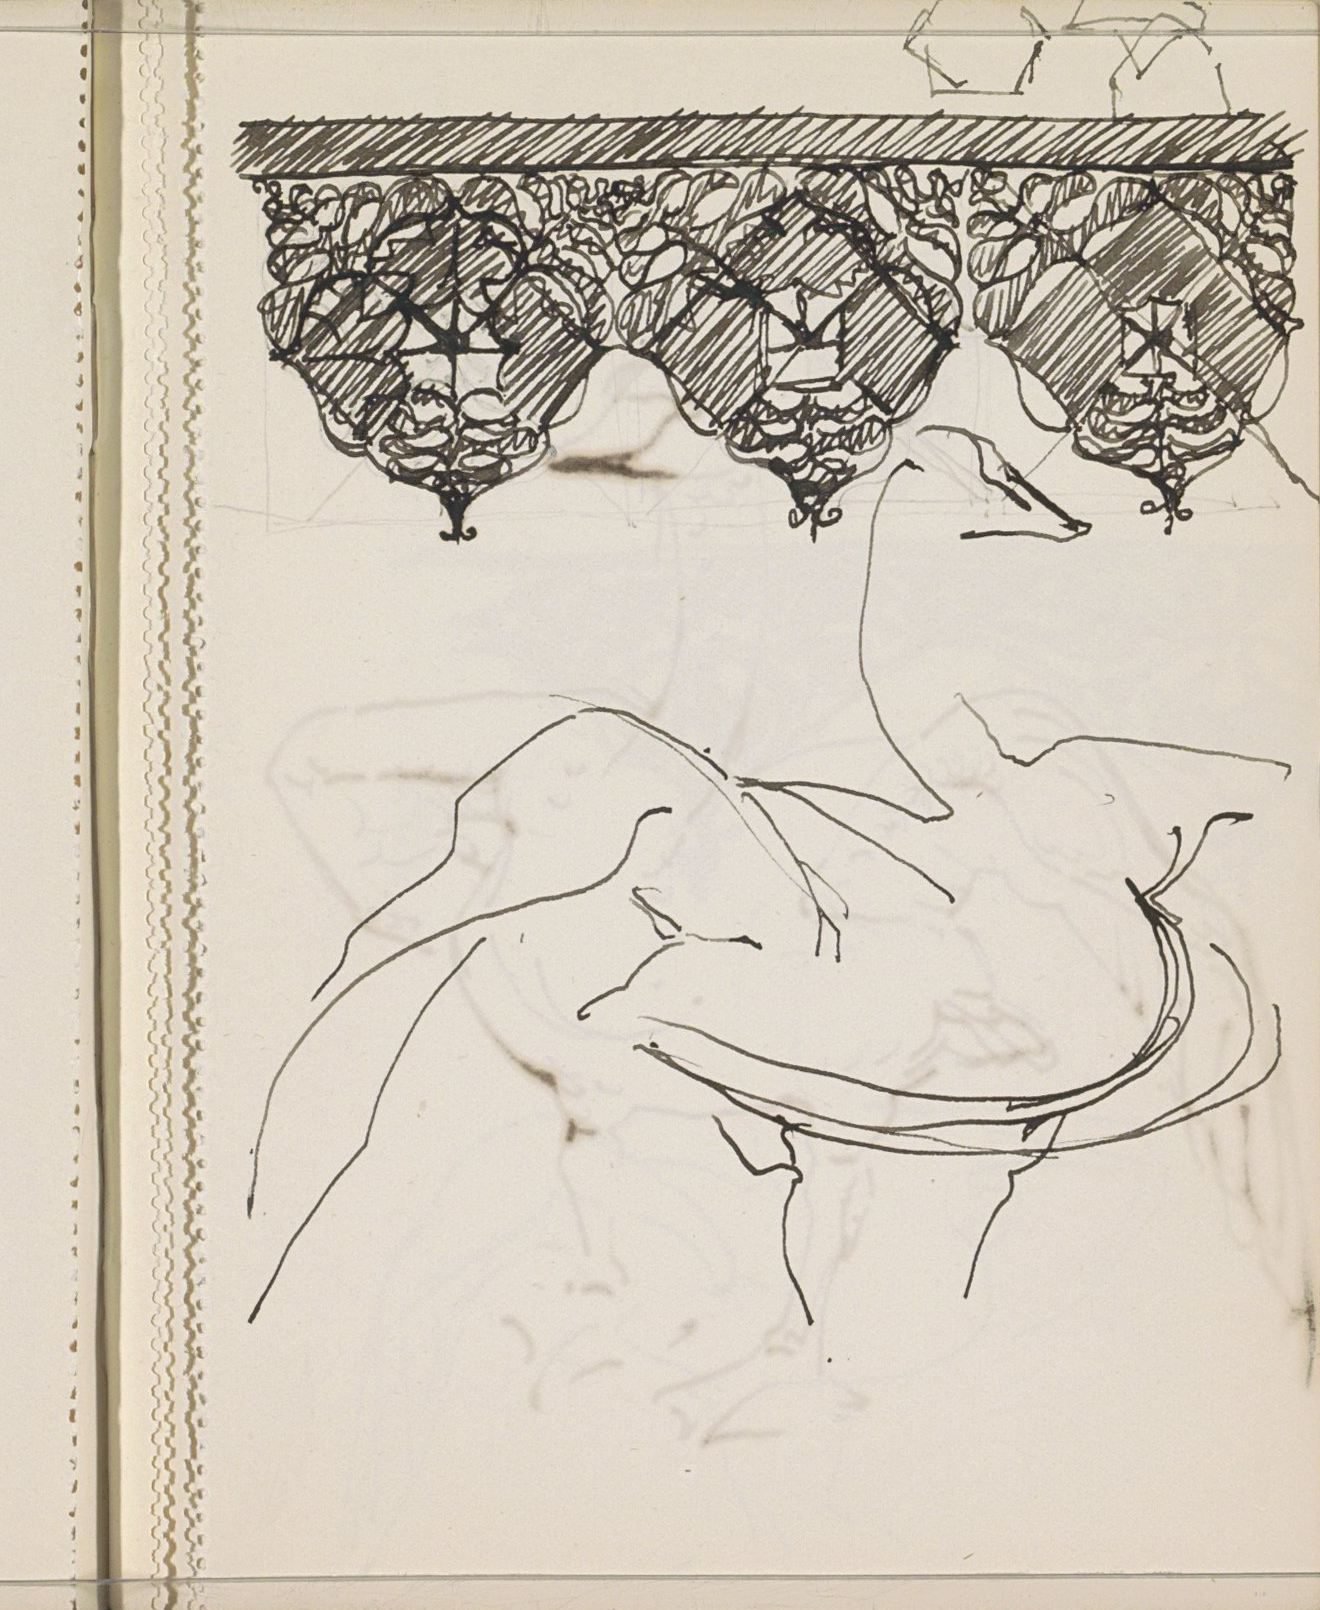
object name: sketchbook leaf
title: Vogel, mogelijk een zwaan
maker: reijer stolk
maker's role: draughtsman, print maker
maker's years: 1896-1945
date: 1906-1945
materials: ink, paper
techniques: pen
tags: ornaments ~ art, birds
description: Tevens studies van ornamenten. Blad 34 recto uit een schetsboek met 42 bladen.